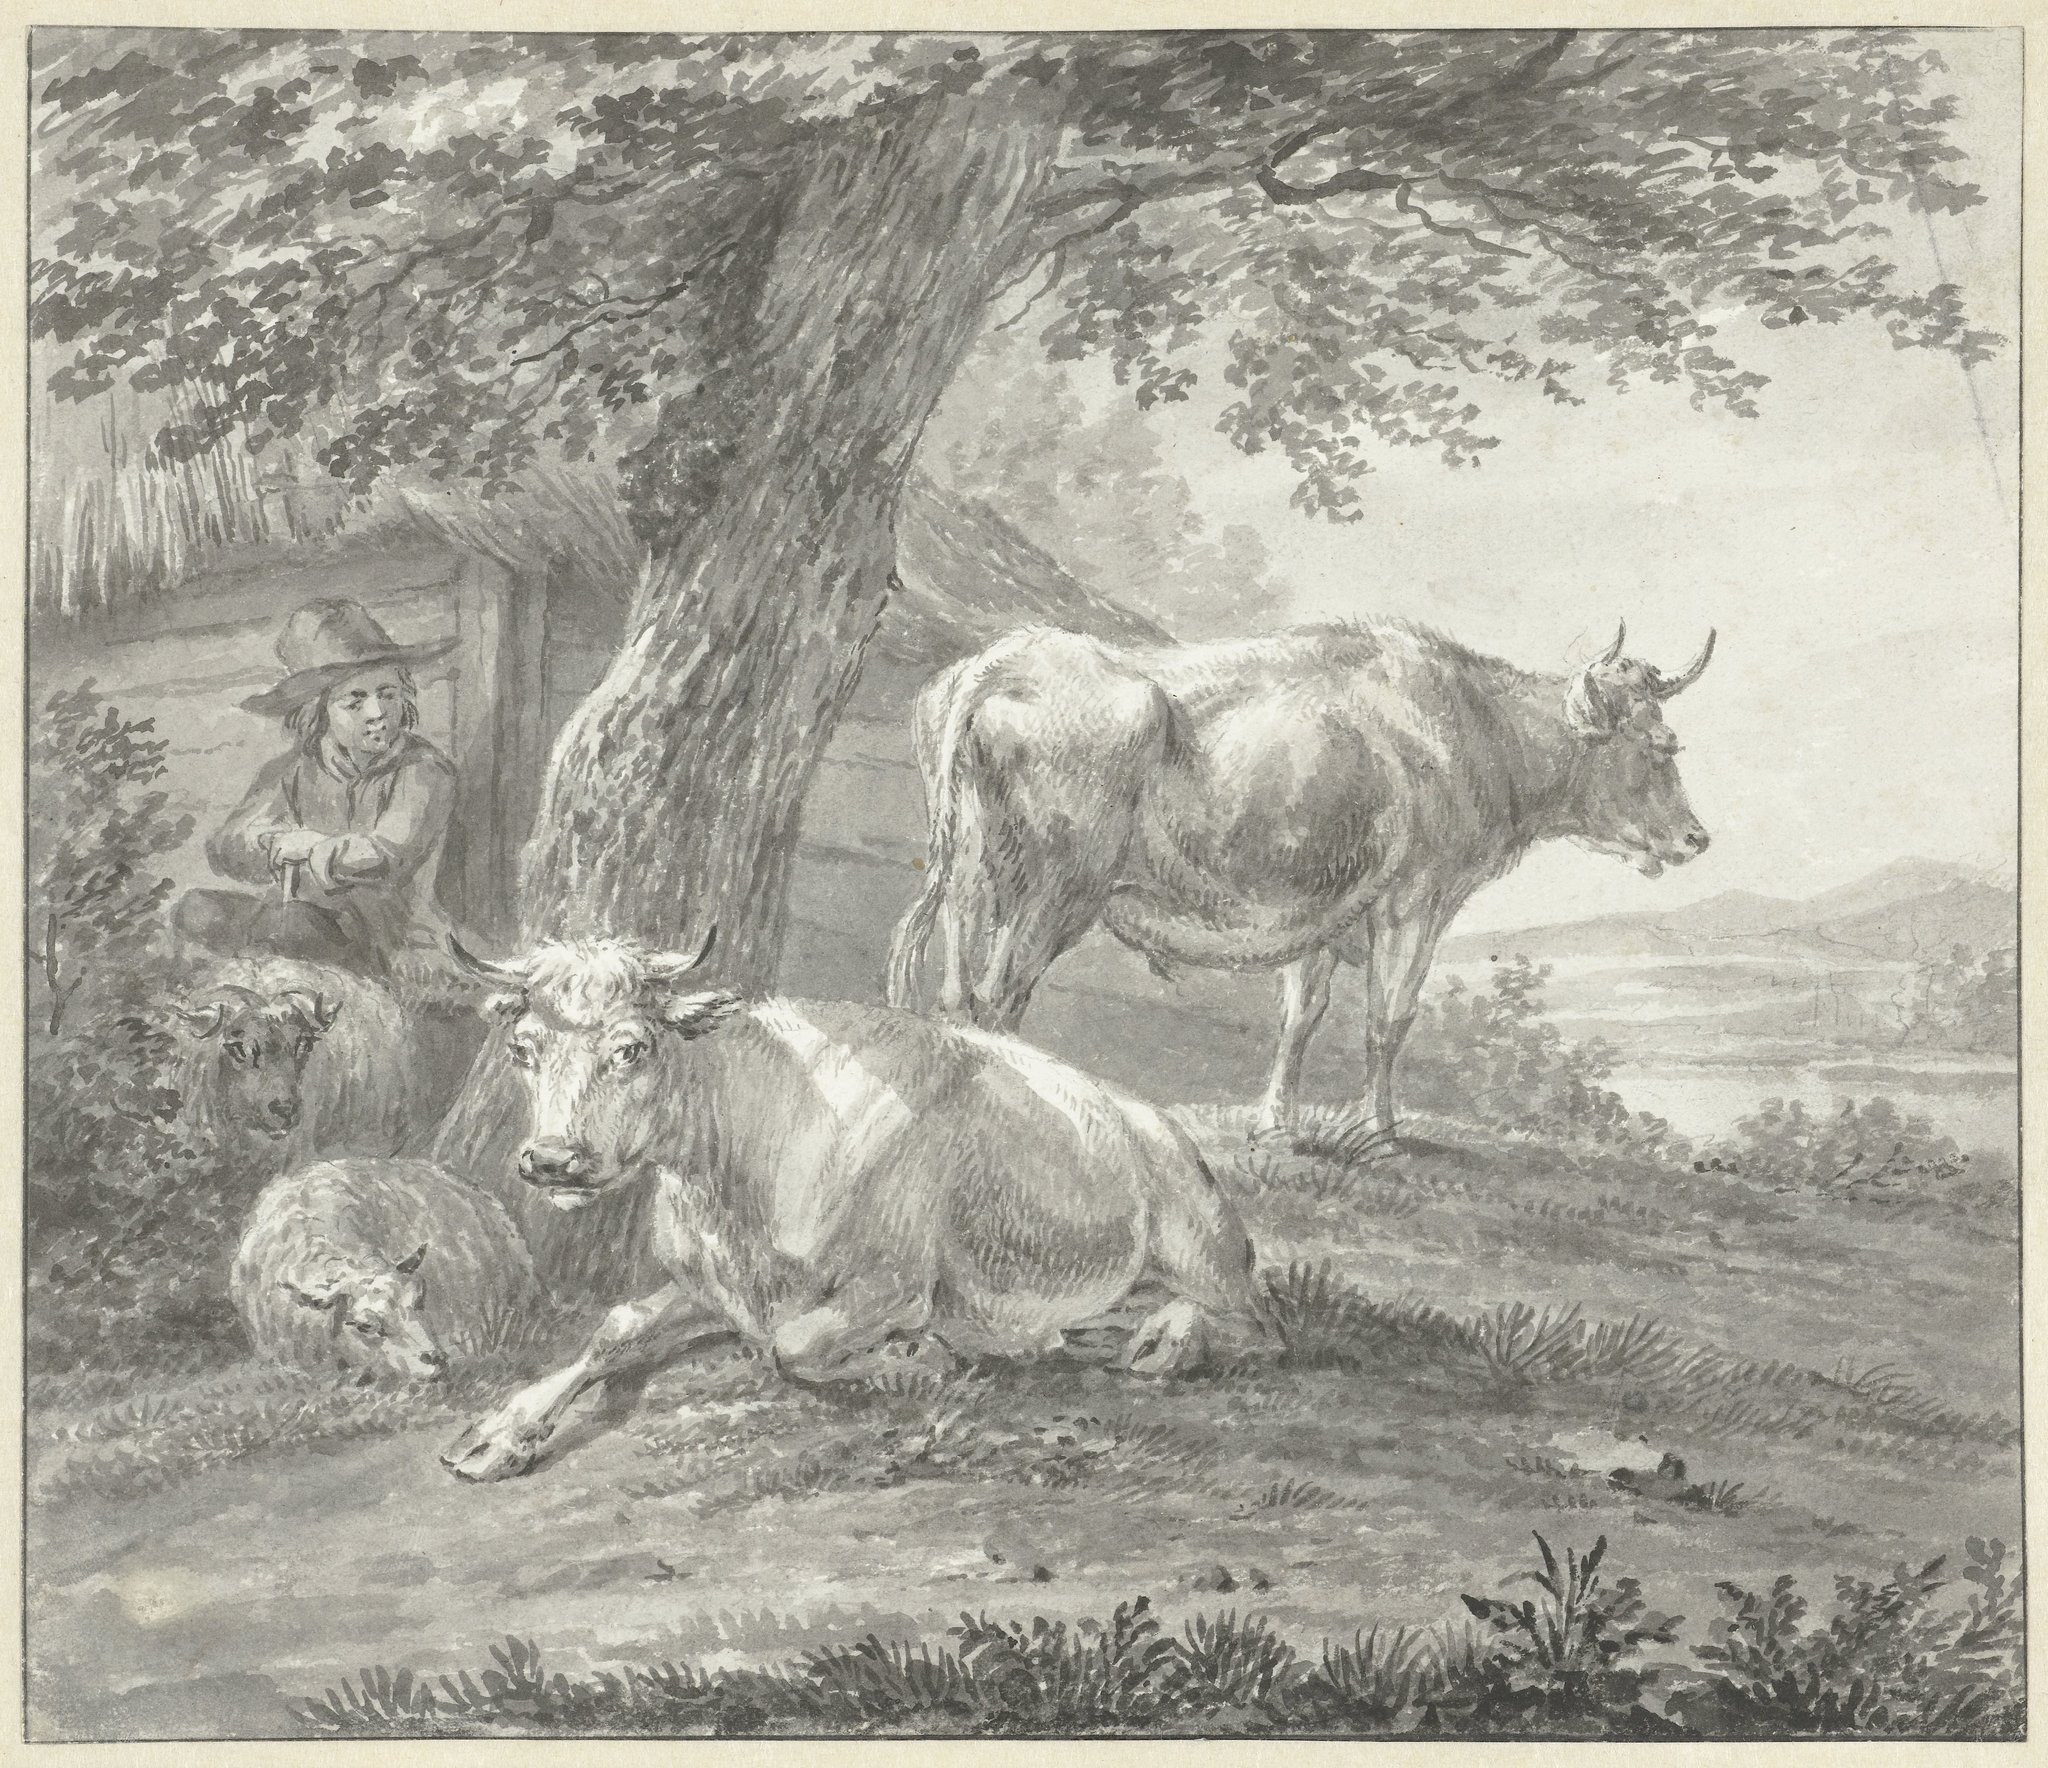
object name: drawing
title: Twee koeien en twee schapen onder een boom bij een schuur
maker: hendrik stokvisch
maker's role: draughtsman, painter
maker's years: 1768-1820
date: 1778-1820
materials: ink, paper, pencil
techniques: brush, pen